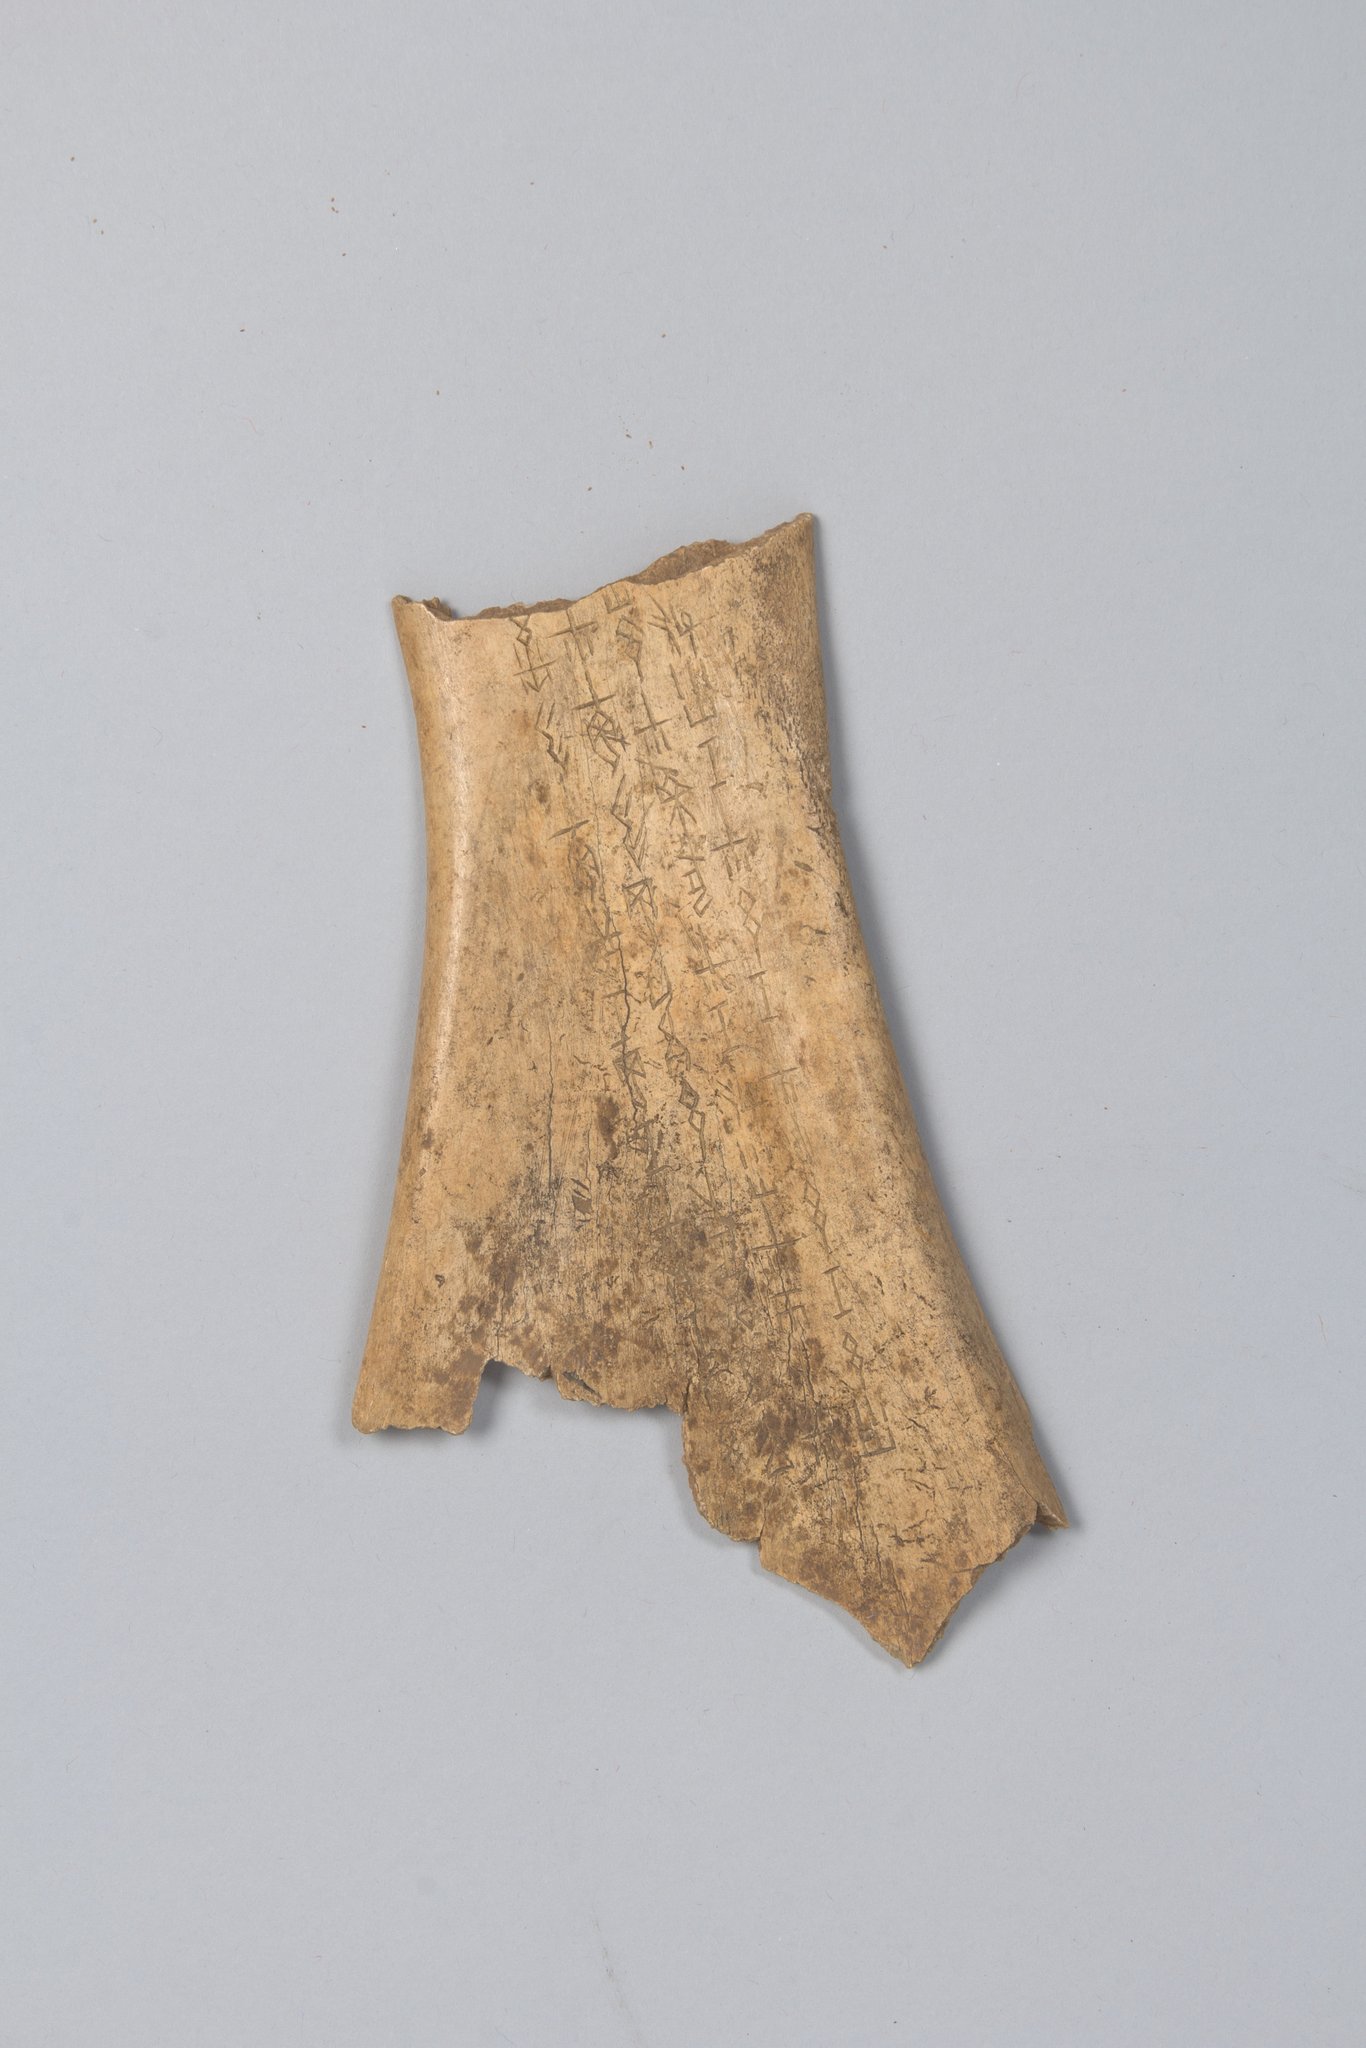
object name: oracle bone fragment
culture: chinese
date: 1610-1036 BCE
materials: bone